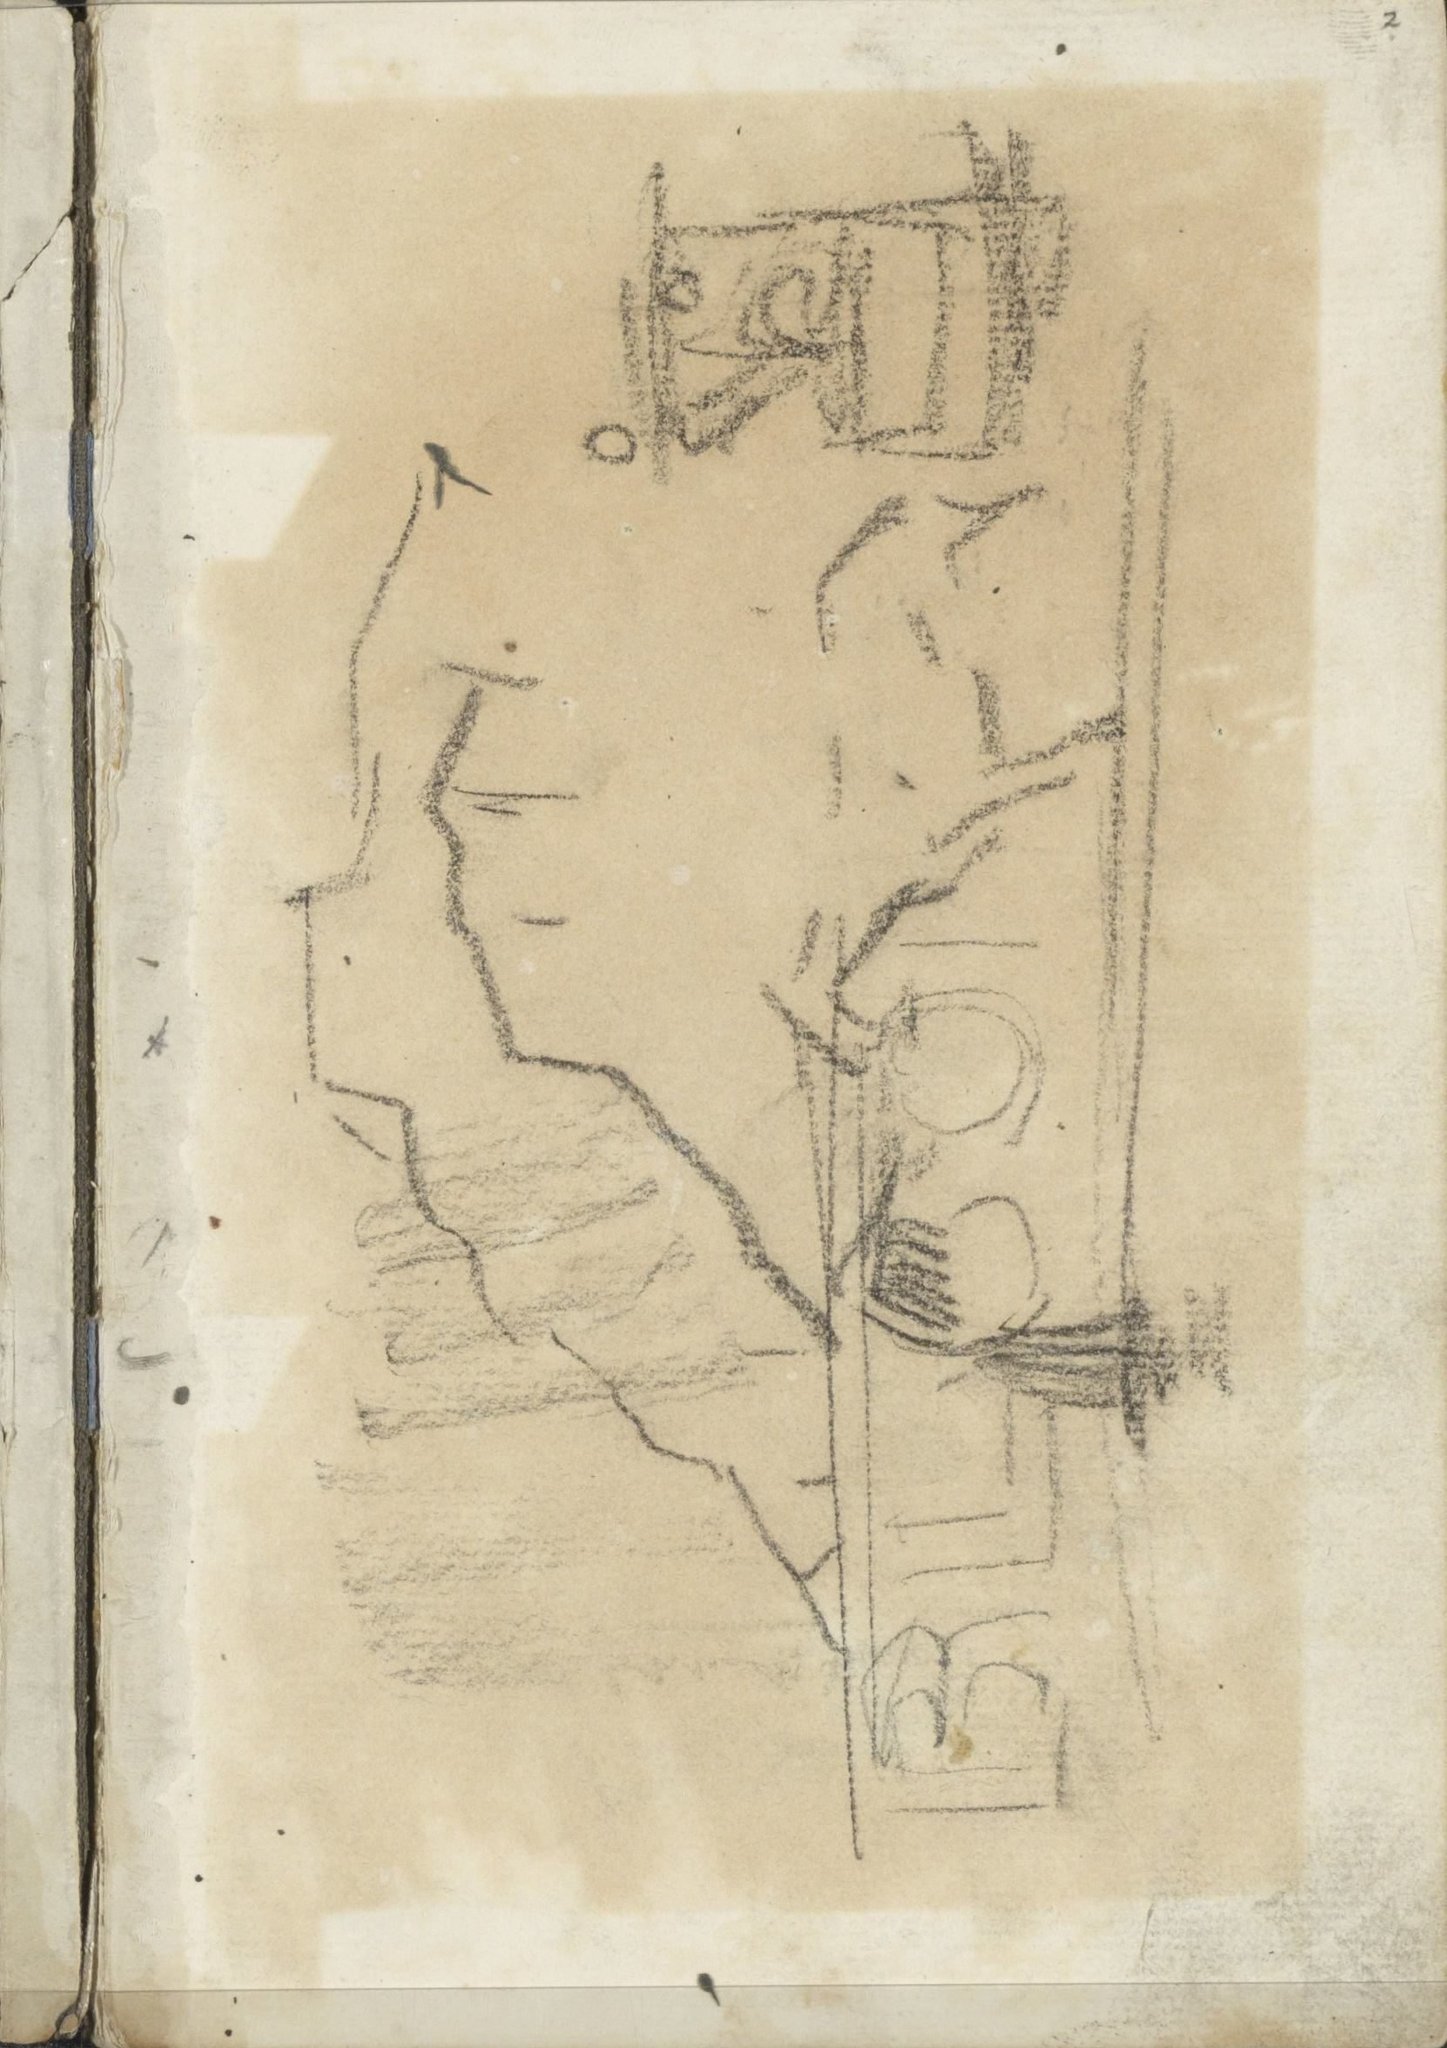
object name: sketchbook leaf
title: Paardentram voor een reclame, mogelijk van Blooker's Cacaofabriek aan de Weesperzijde te Amsterdam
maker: george hendrik breitner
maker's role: draughtsman, painter, print maker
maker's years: 1857-1923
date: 1895-1898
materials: chalk, paper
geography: amsterdam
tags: diligence, omnibus, horse-tram, advertising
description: Pagina 2 uit een schetsboek met 20 bladen.